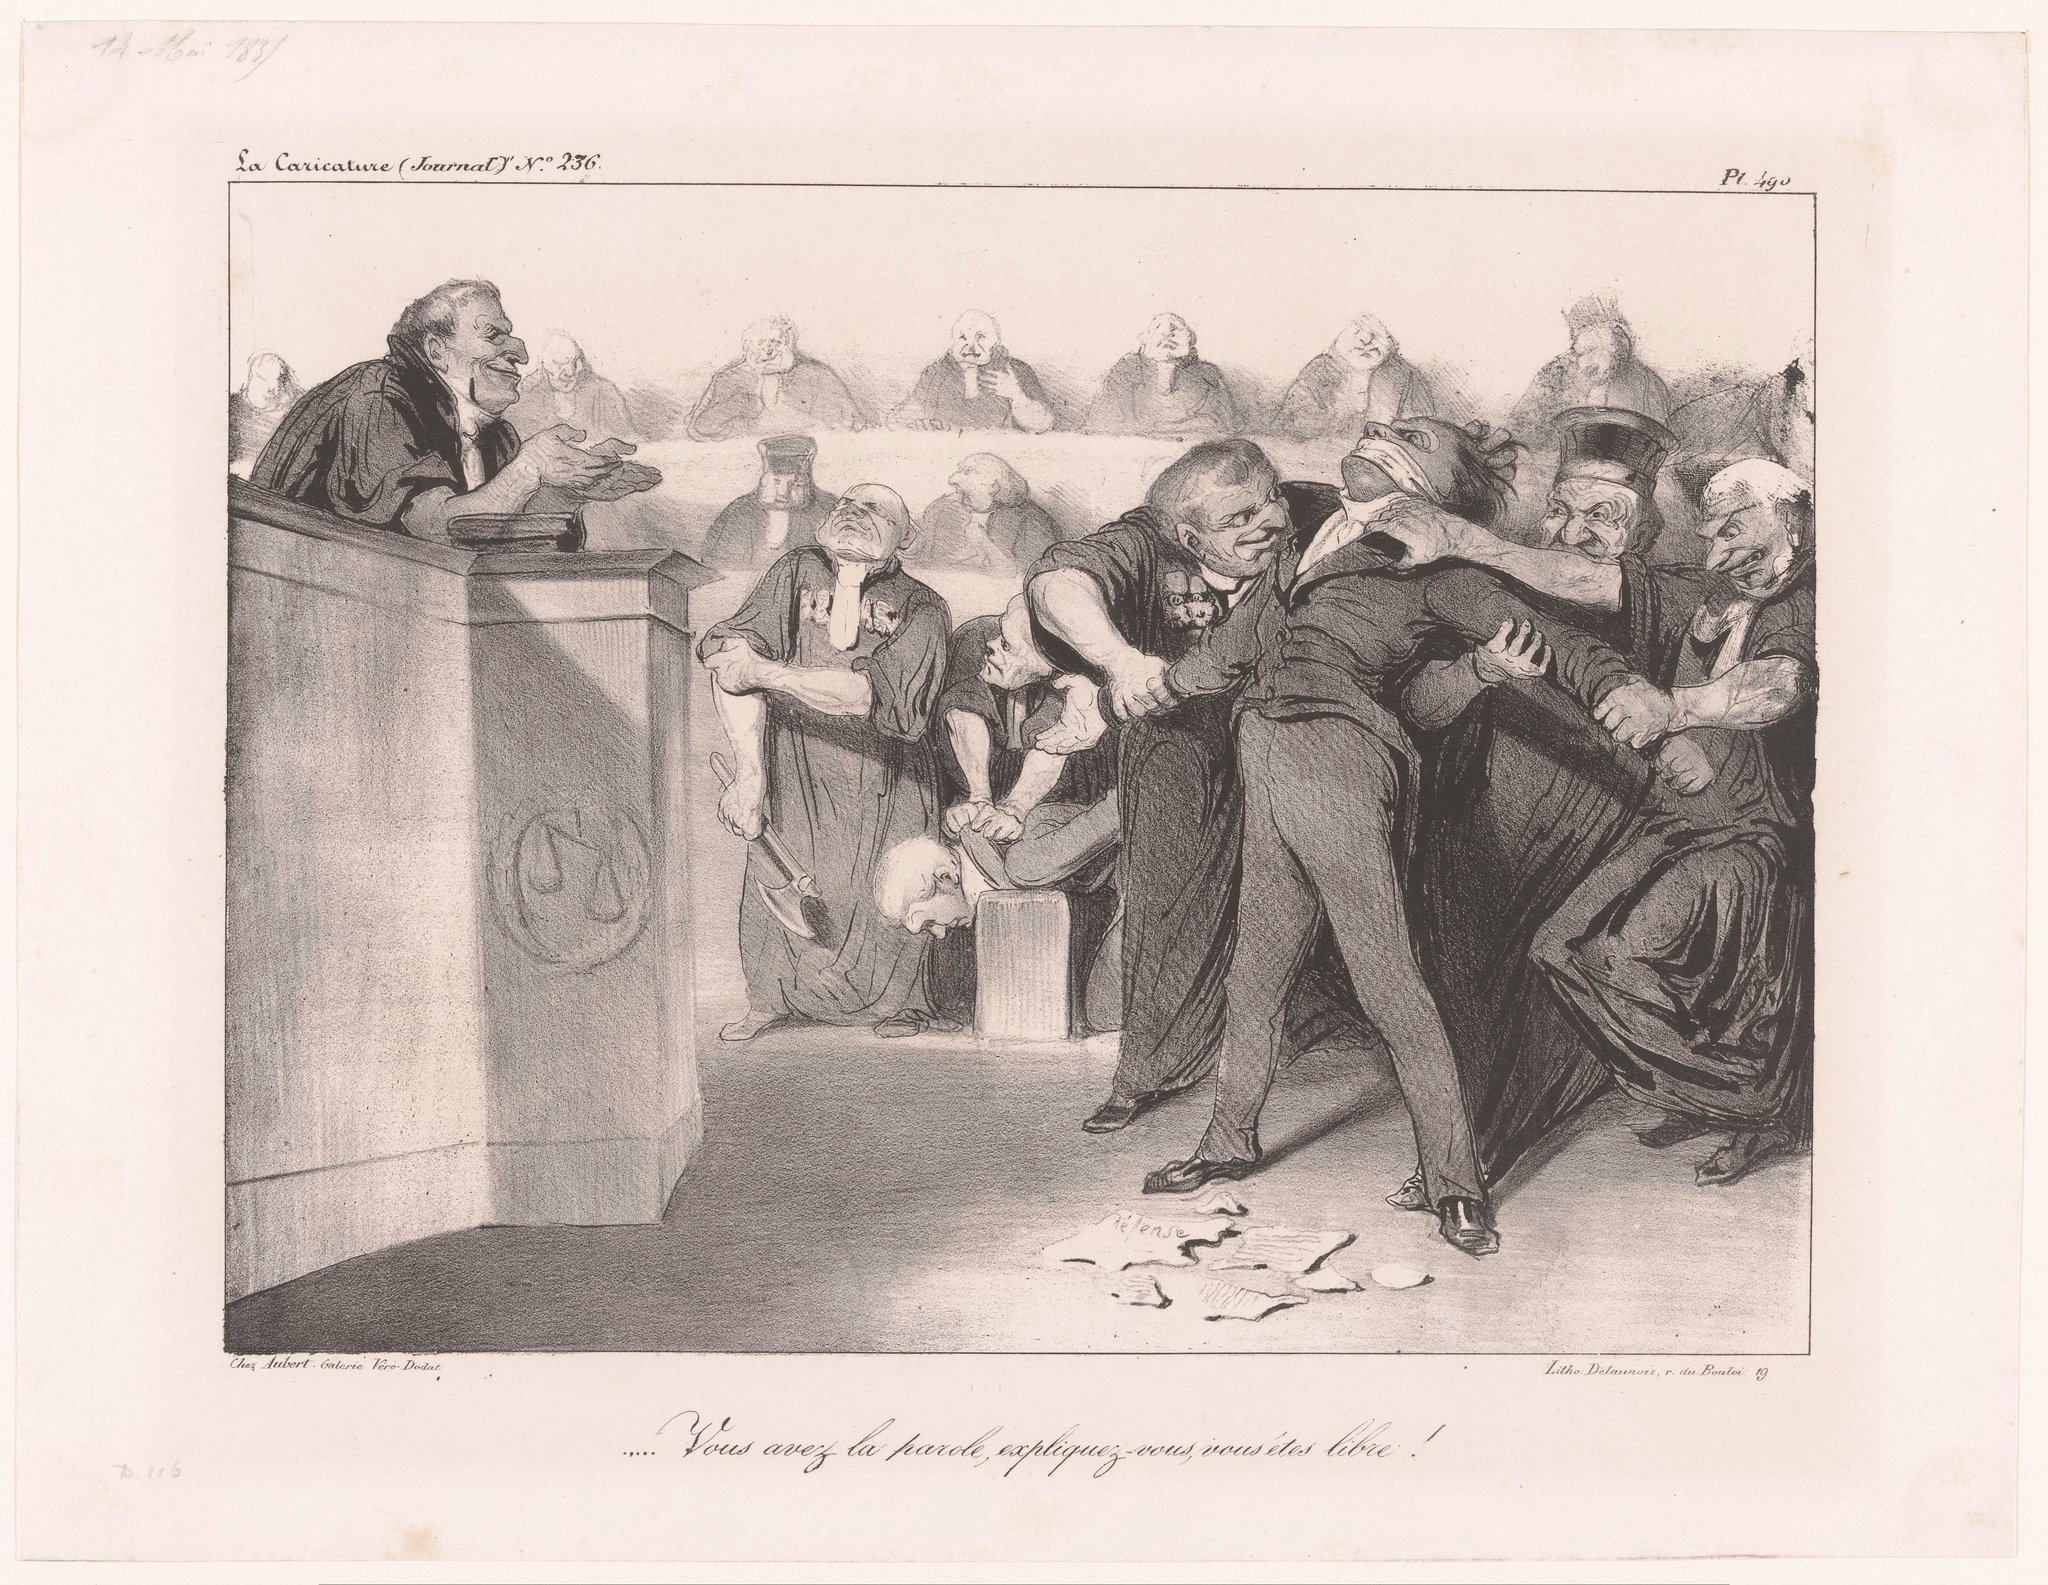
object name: cartoon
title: Karikatuur van een zitting van het tribunaal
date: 1835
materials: paper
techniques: lithograph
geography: paris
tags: caricatures (human types), political tribunal, court session (court of justice), political caricatures and satires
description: De rechter geeft de beschuldigde politicus de gelegenheid om zich te verdedigen, maar drie juristen snoeren hem letterlijk de mond.